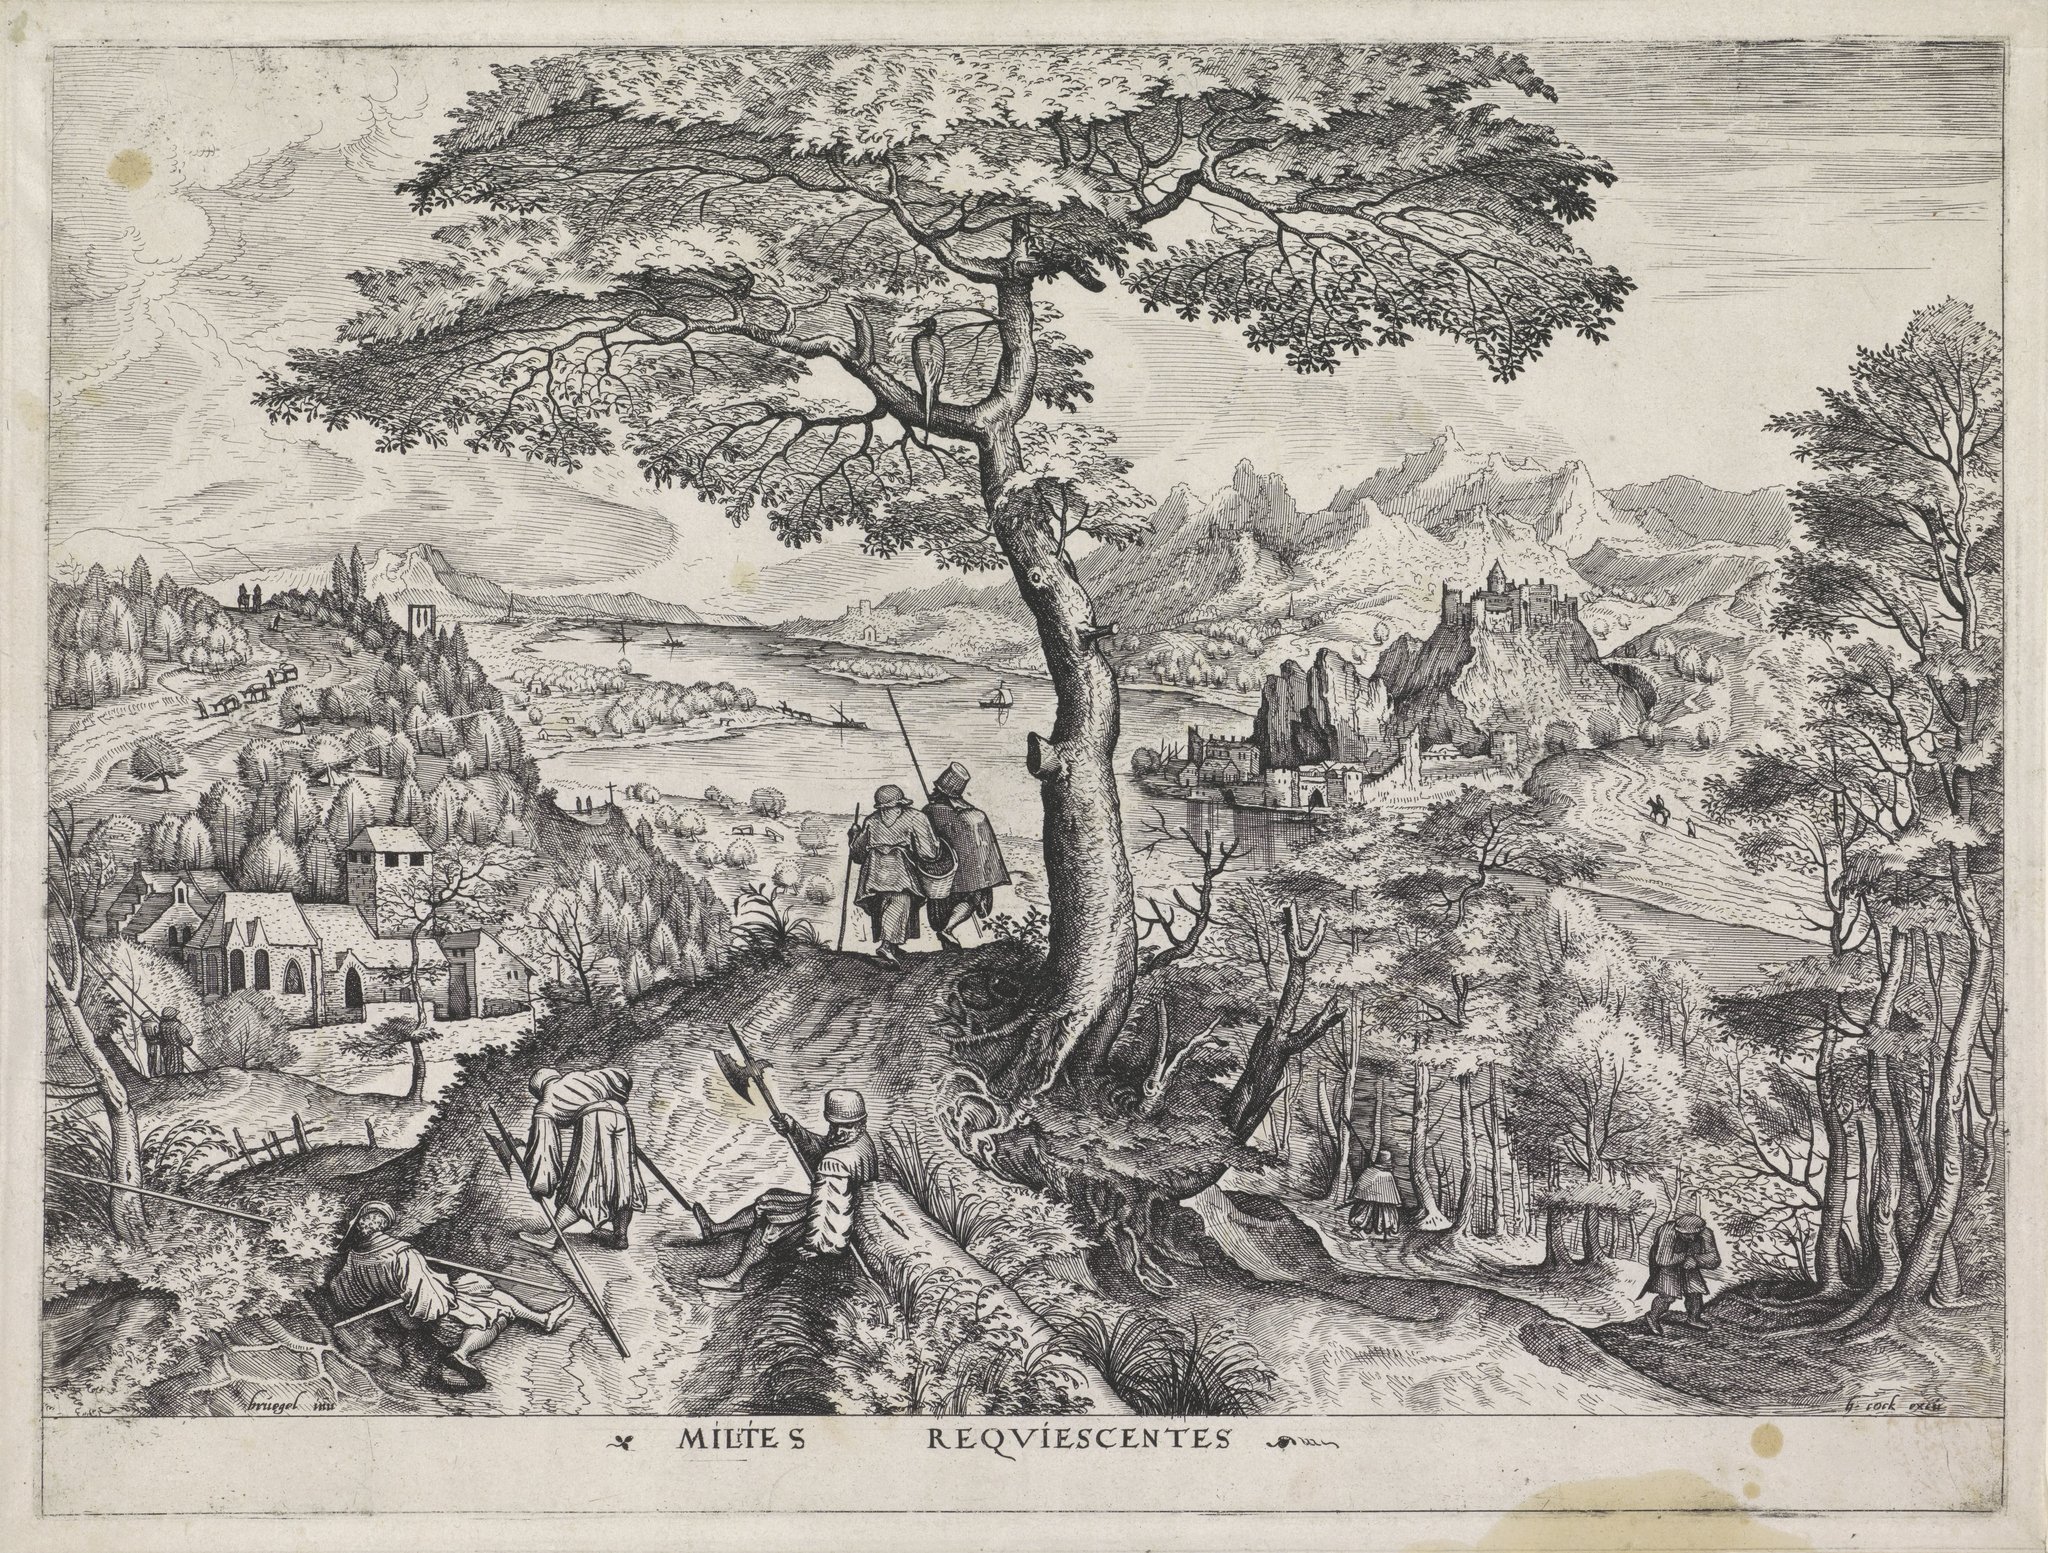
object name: print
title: Grote landschappen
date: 1553-1558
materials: paper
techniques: engraving, etching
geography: antwerp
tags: trees, river, (traveller) resting in the open air, the soldier off duty, 'en route', traveller under way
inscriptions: collector's mark: Lugt 240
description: Landschap met rustende soldaten. Glooiend landschap met grote boom in het midden op de voorgrond. Op de landweg ernaast lopen twee mannen, op de rug gezien. Drie soldaten zitten op de grond. Rivier en heuvels op de achtergrond.